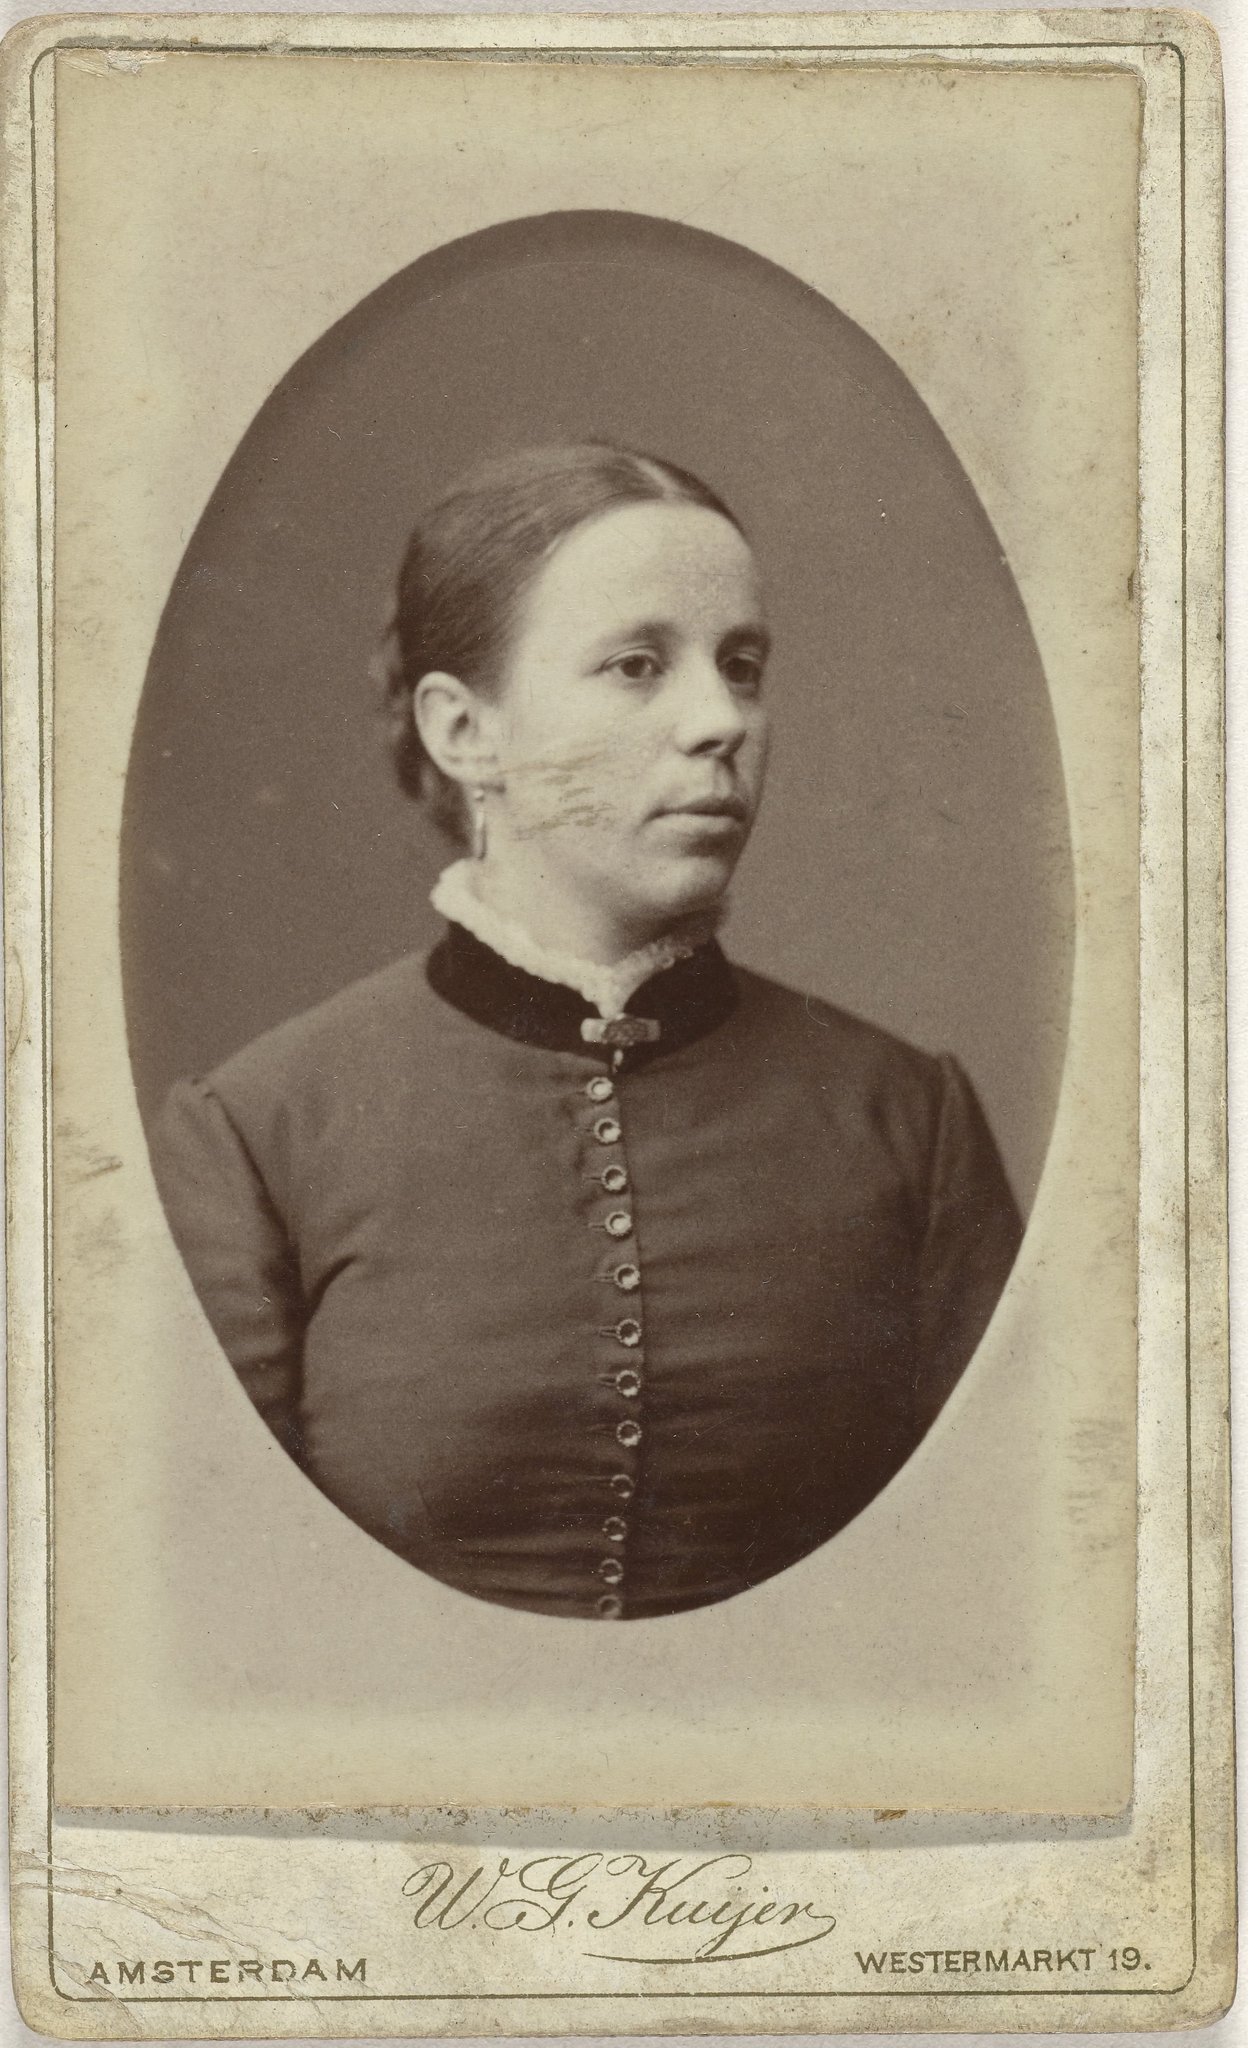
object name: photograph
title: Ovaal studioportret van vrouw, buste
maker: willem gerhardus kuijer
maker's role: fotograaf, hoffotograaf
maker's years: 1834-1899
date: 1880-1920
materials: photographic support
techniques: albumen print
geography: amsterdam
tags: amsterdam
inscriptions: name: ‘W.G. Kuijer Westermarkt 19 Amsterdam’